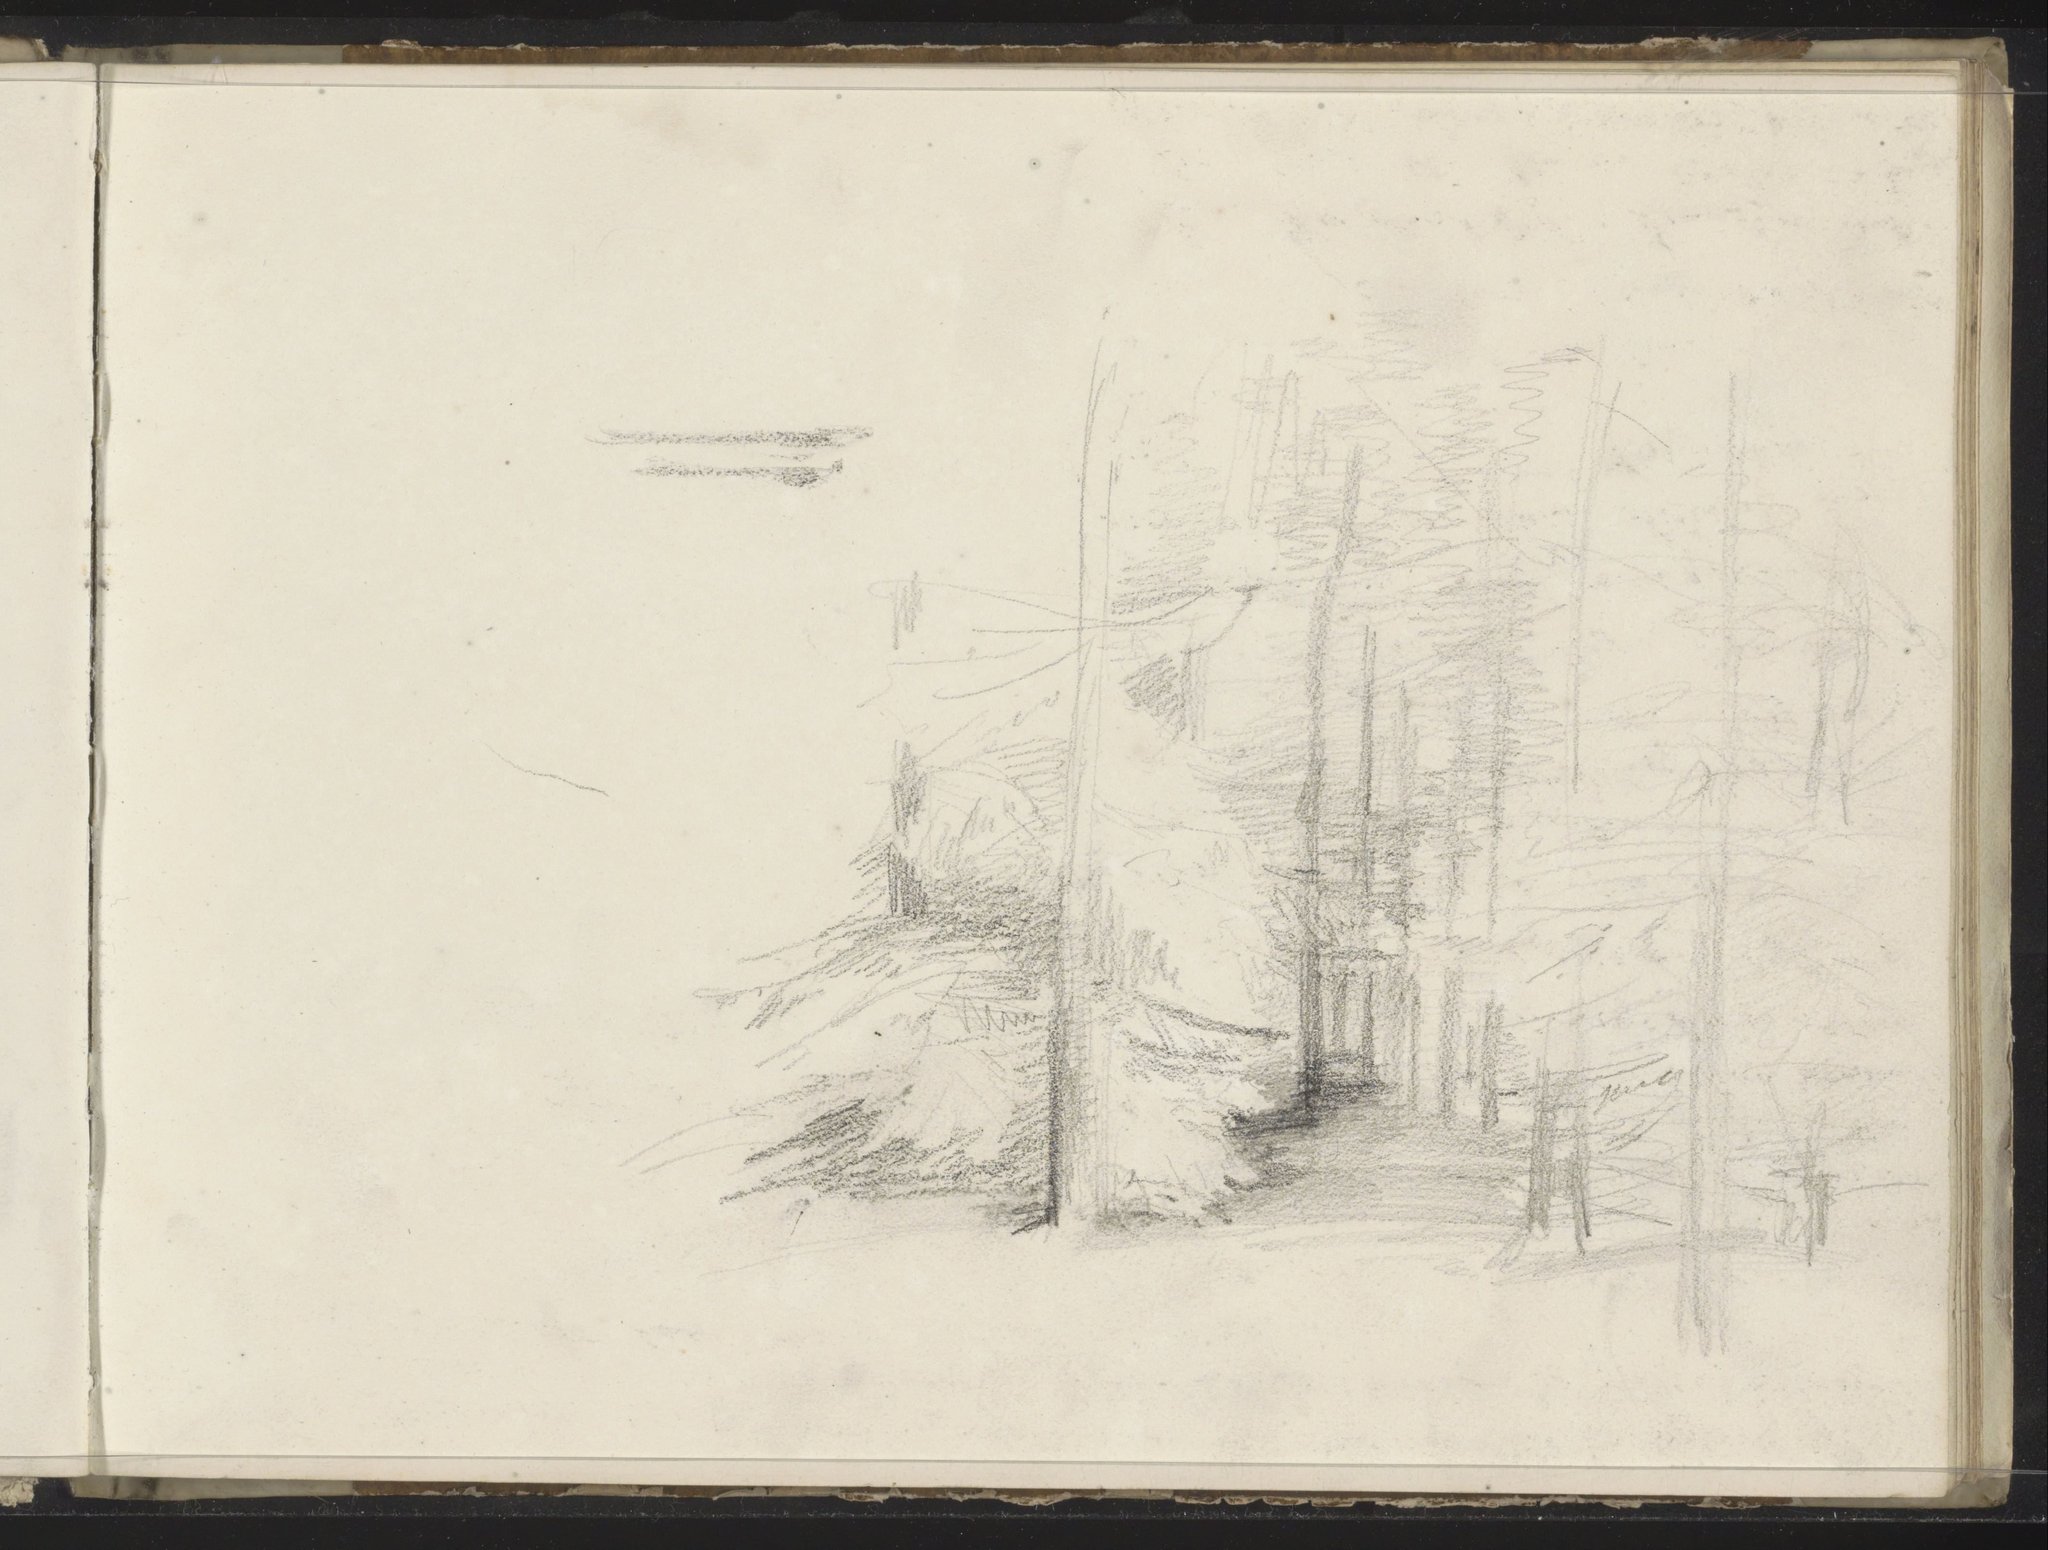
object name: sketchbook leaf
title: Bospad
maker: maria vos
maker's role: draughtsman, painter, print maker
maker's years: 1824-1906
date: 1834-1906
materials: paper, pencil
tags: forest path or lane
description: Blad 7 recto uit een schetsboek met 39 bladen.